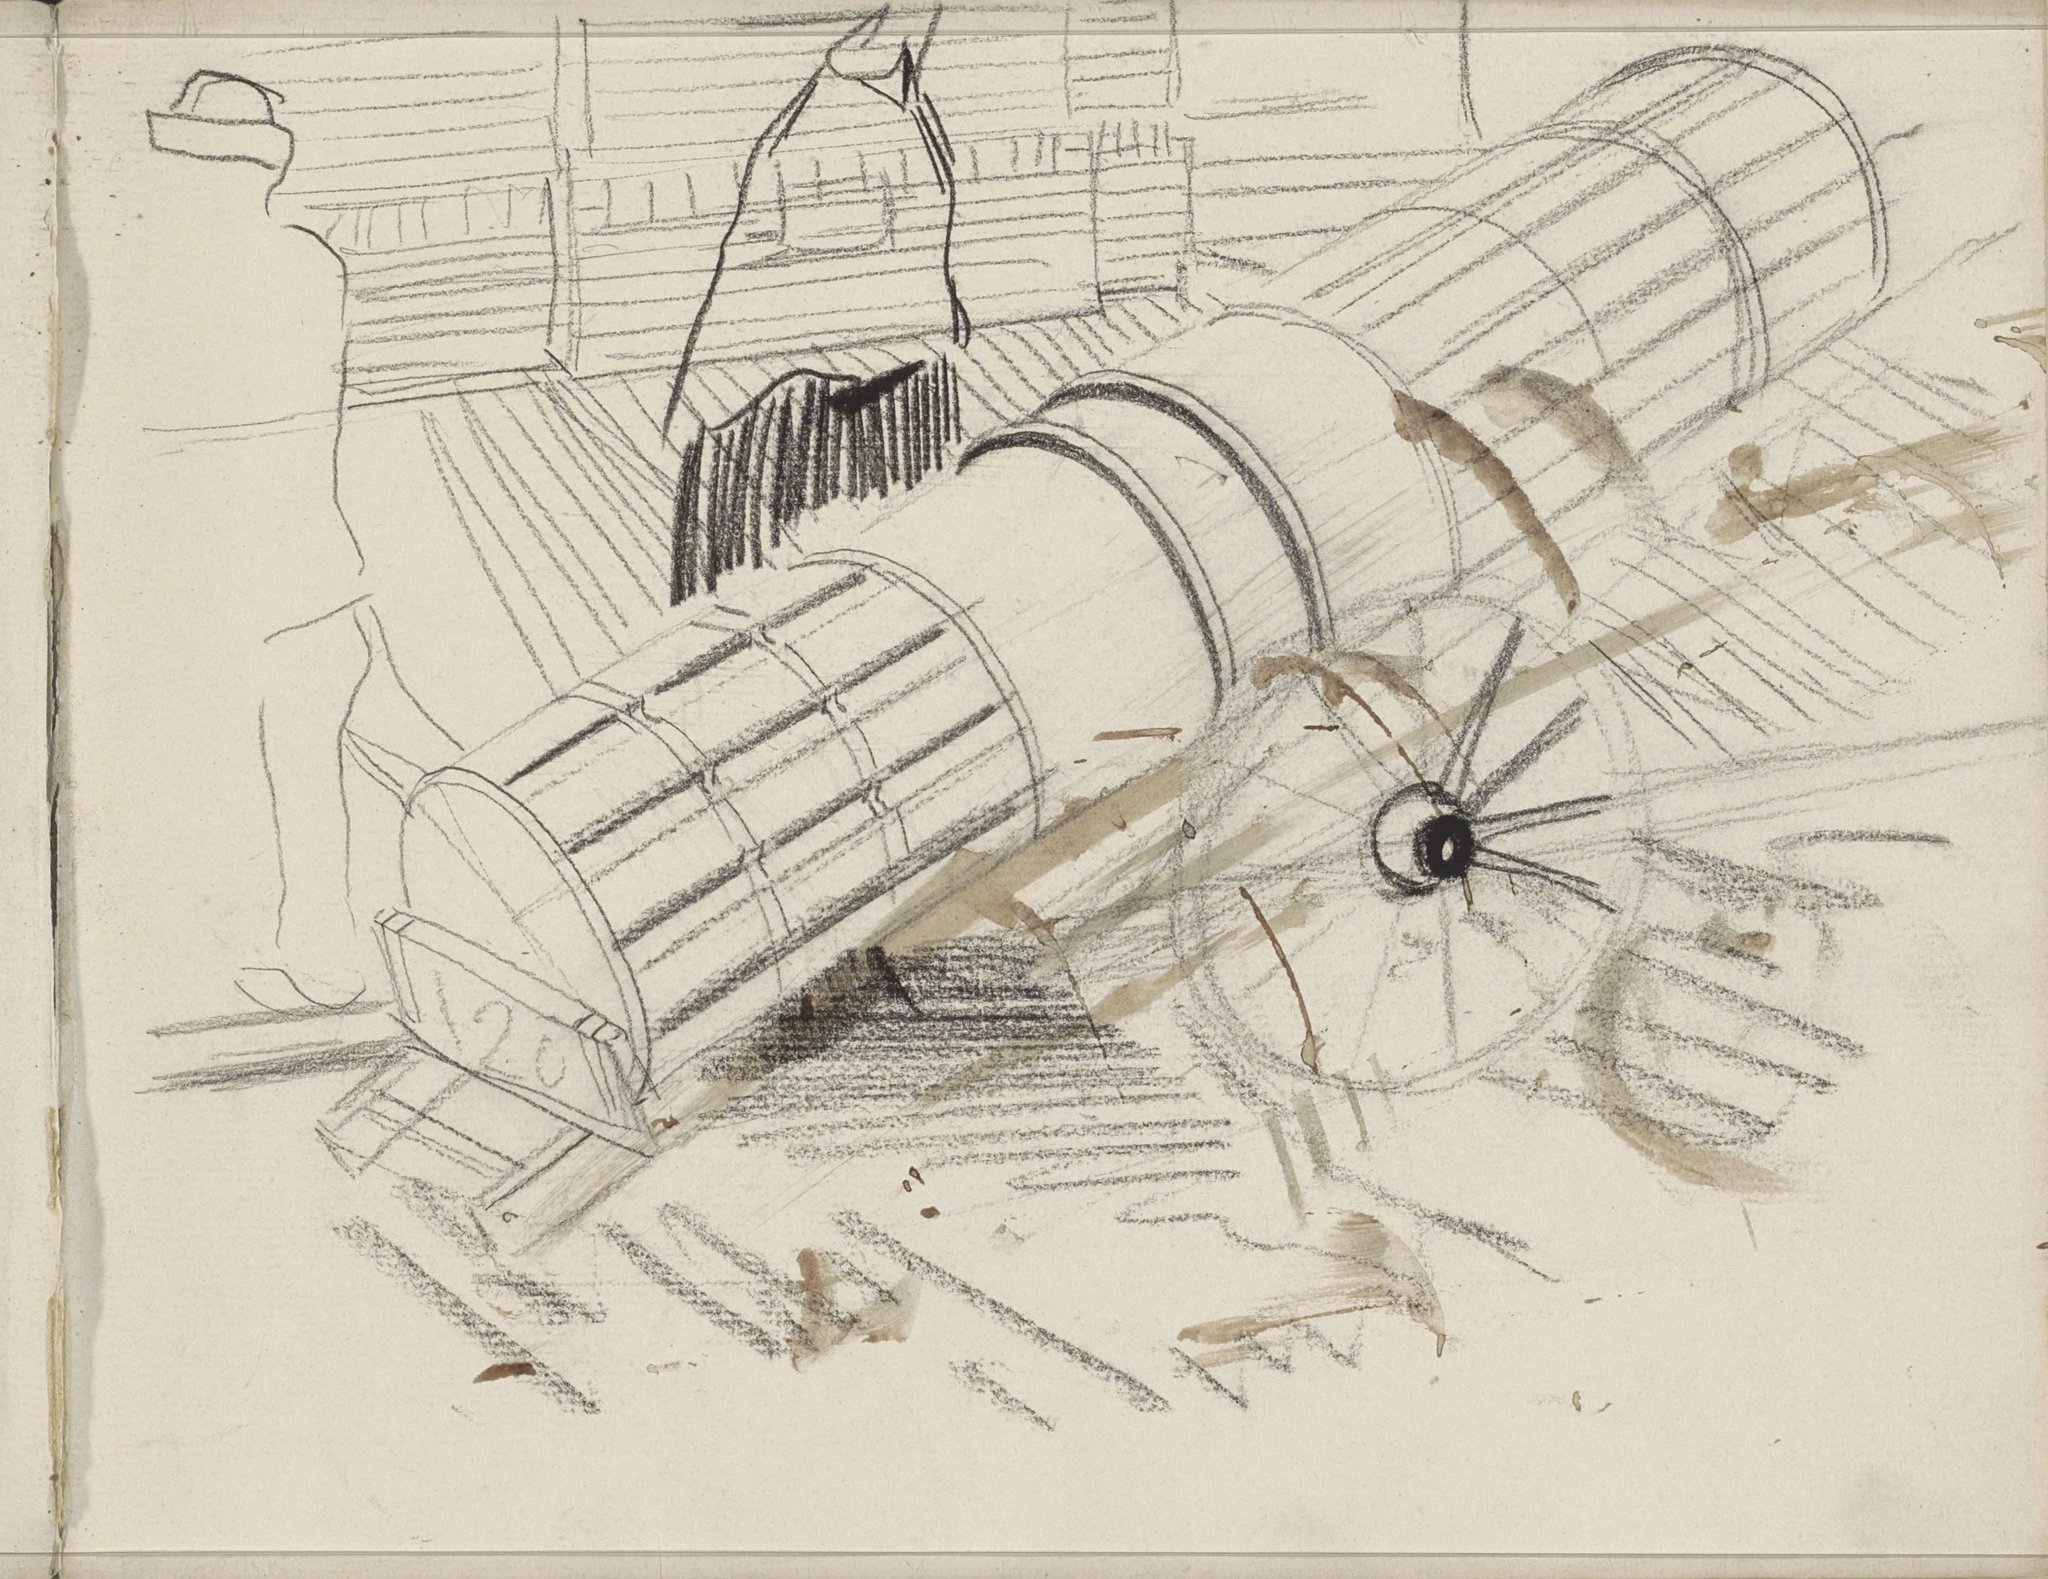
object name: sketchbook leaf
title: Kanon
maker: carel adolph lion cachet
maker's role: draughtsman, print maker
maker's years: 1864-1945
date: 1896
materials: chalk, paper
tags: firearms: cannon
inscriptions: number: ‘120’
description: Blad 8 recto uit een schetsboek met 44 bladen.